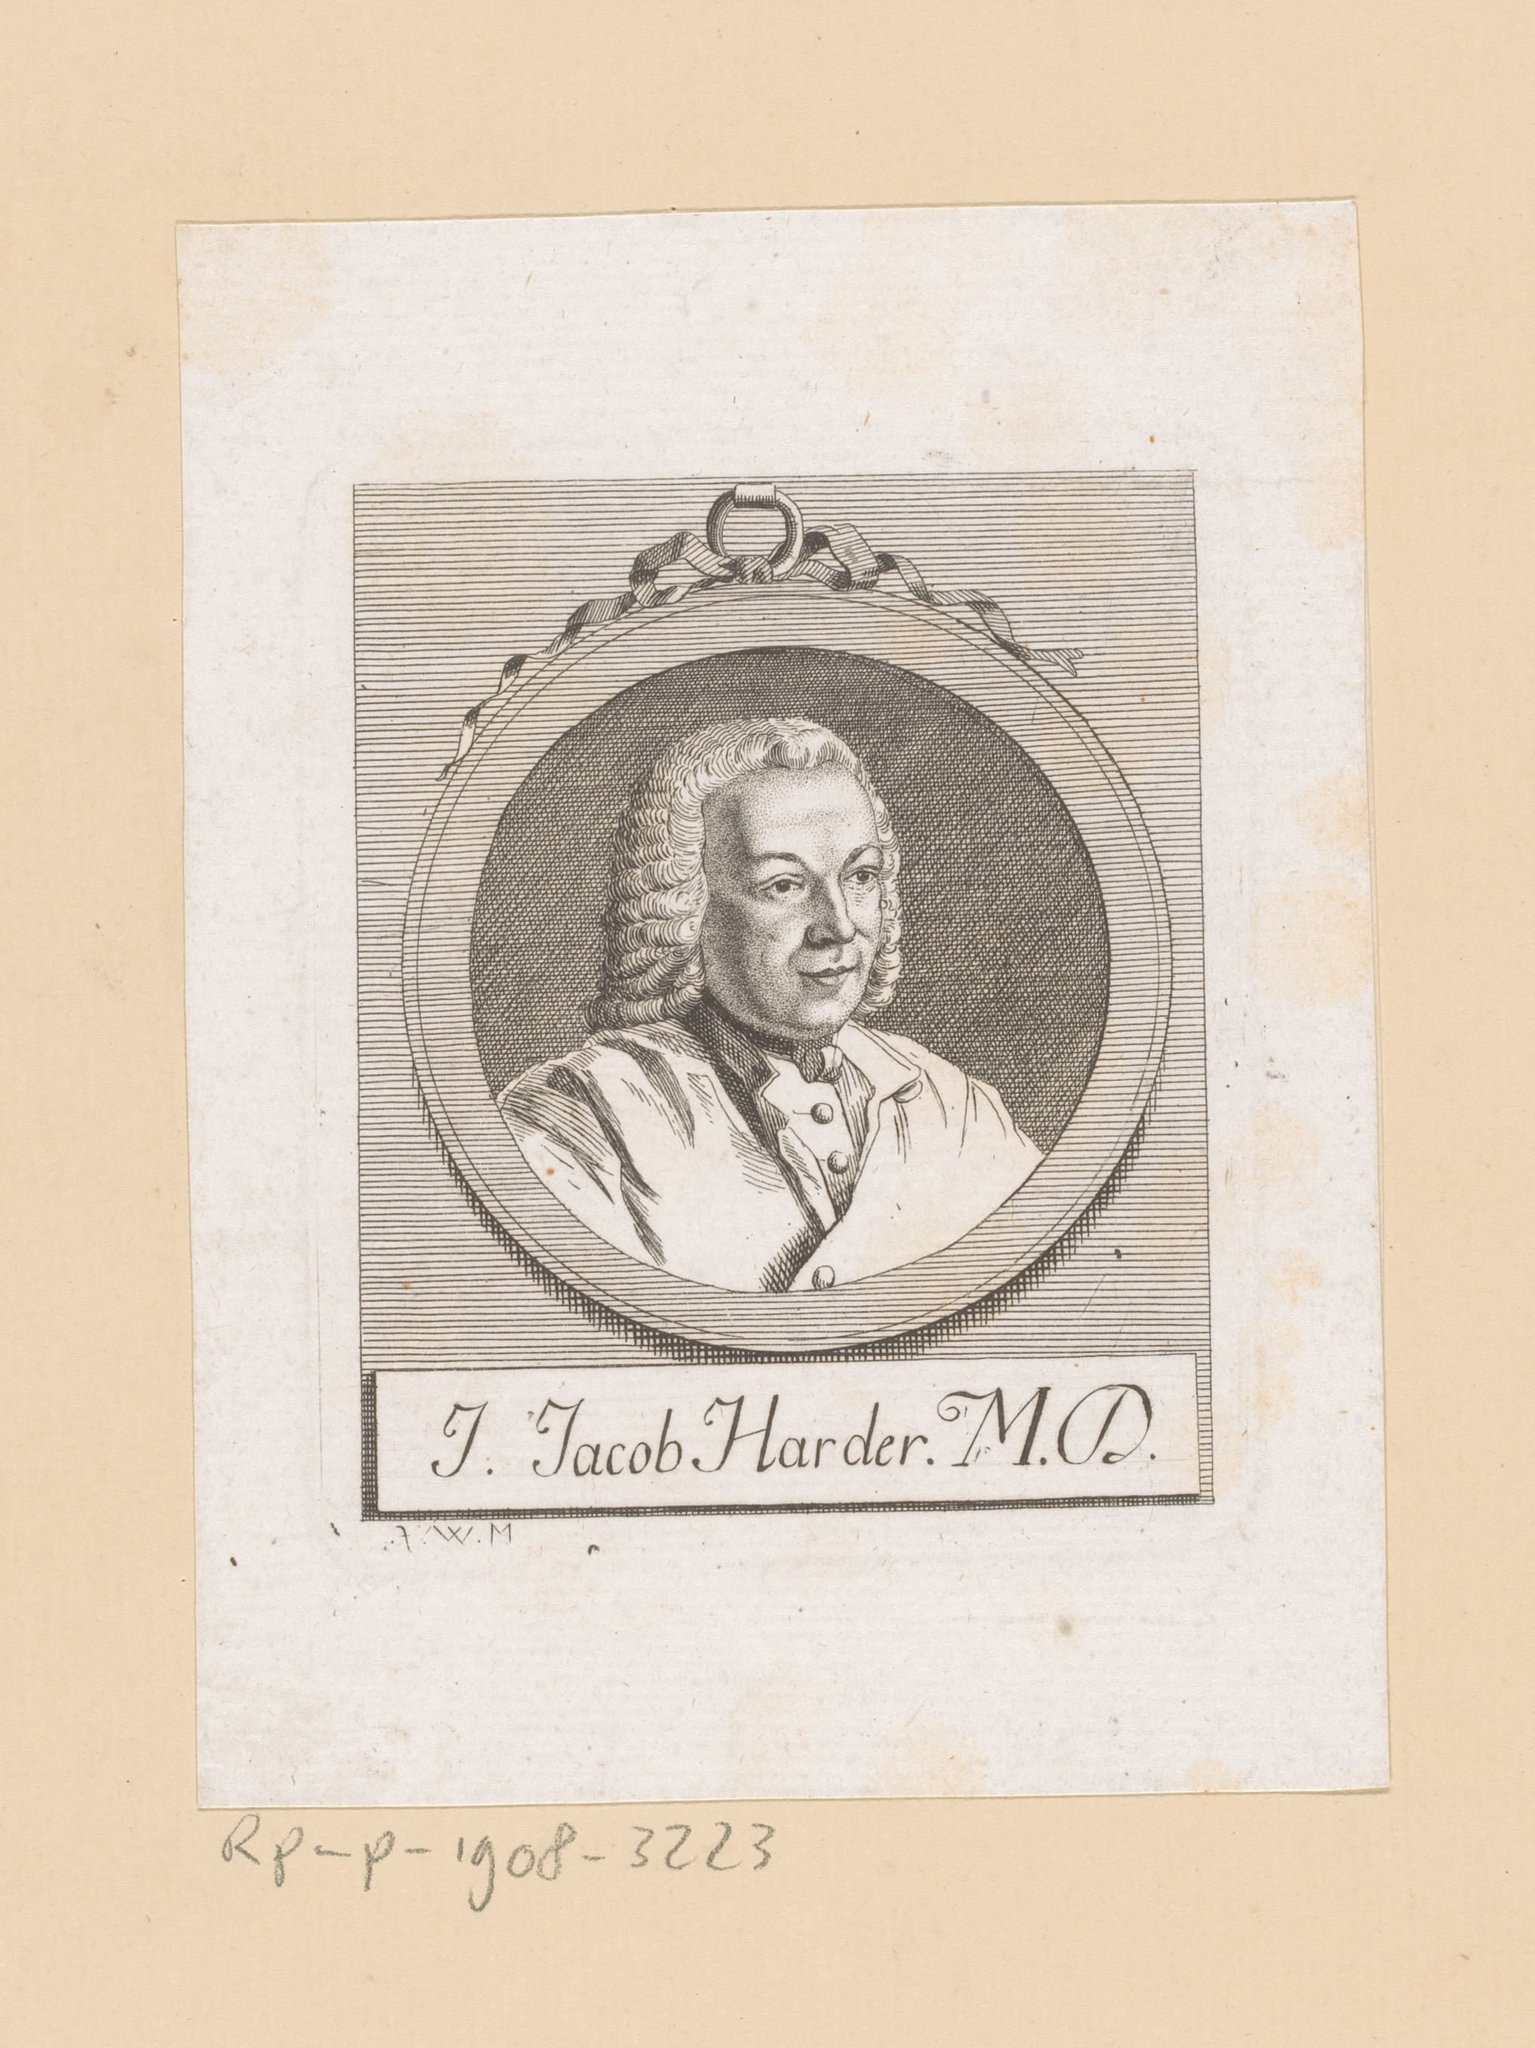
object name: print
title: Winterlandschap met hut bij twee bomen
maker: jerôme tuyttens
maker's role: painter, print maker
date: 1850-1883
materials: paper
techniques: drypoint, etching, intaglio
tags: snow, hut, cabin, lodge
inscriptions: collector's mark: Lugt 2228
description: Sterfdatum van de prentmaker is onbekend. Daarom is voor de bepaling van de rechten van dit object gebruik gemaakt van de verwervingsdatum Rijksmuseum Amsterdam.